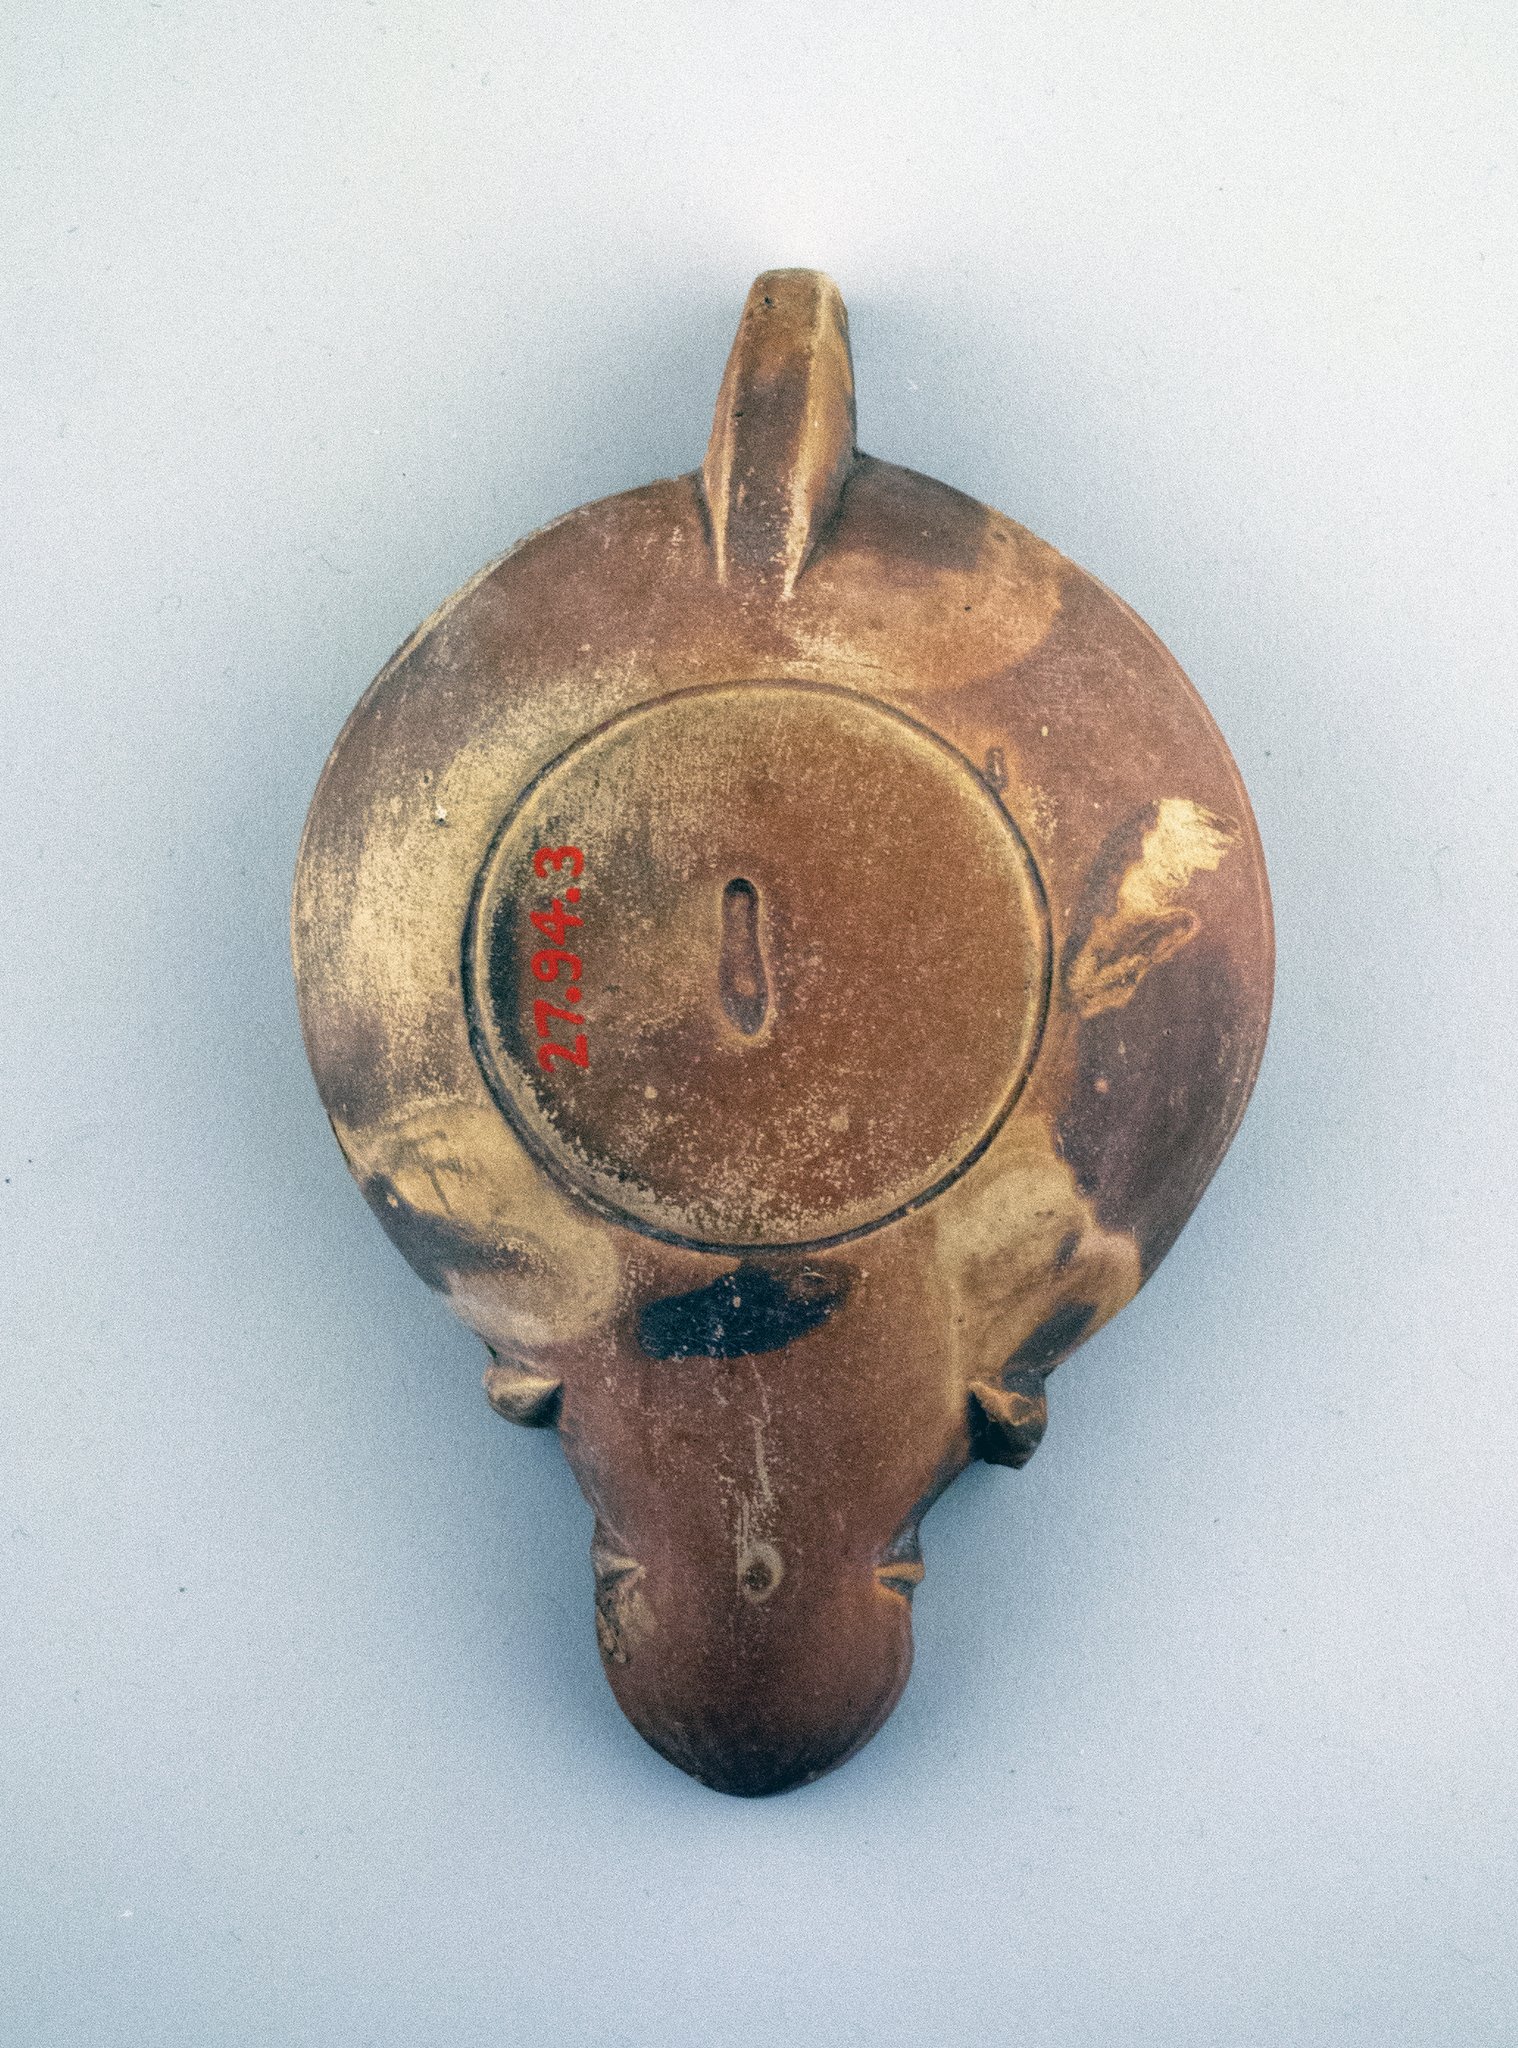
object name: lamp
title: Terracotta oil lamp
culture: roman, italian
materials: terracotta